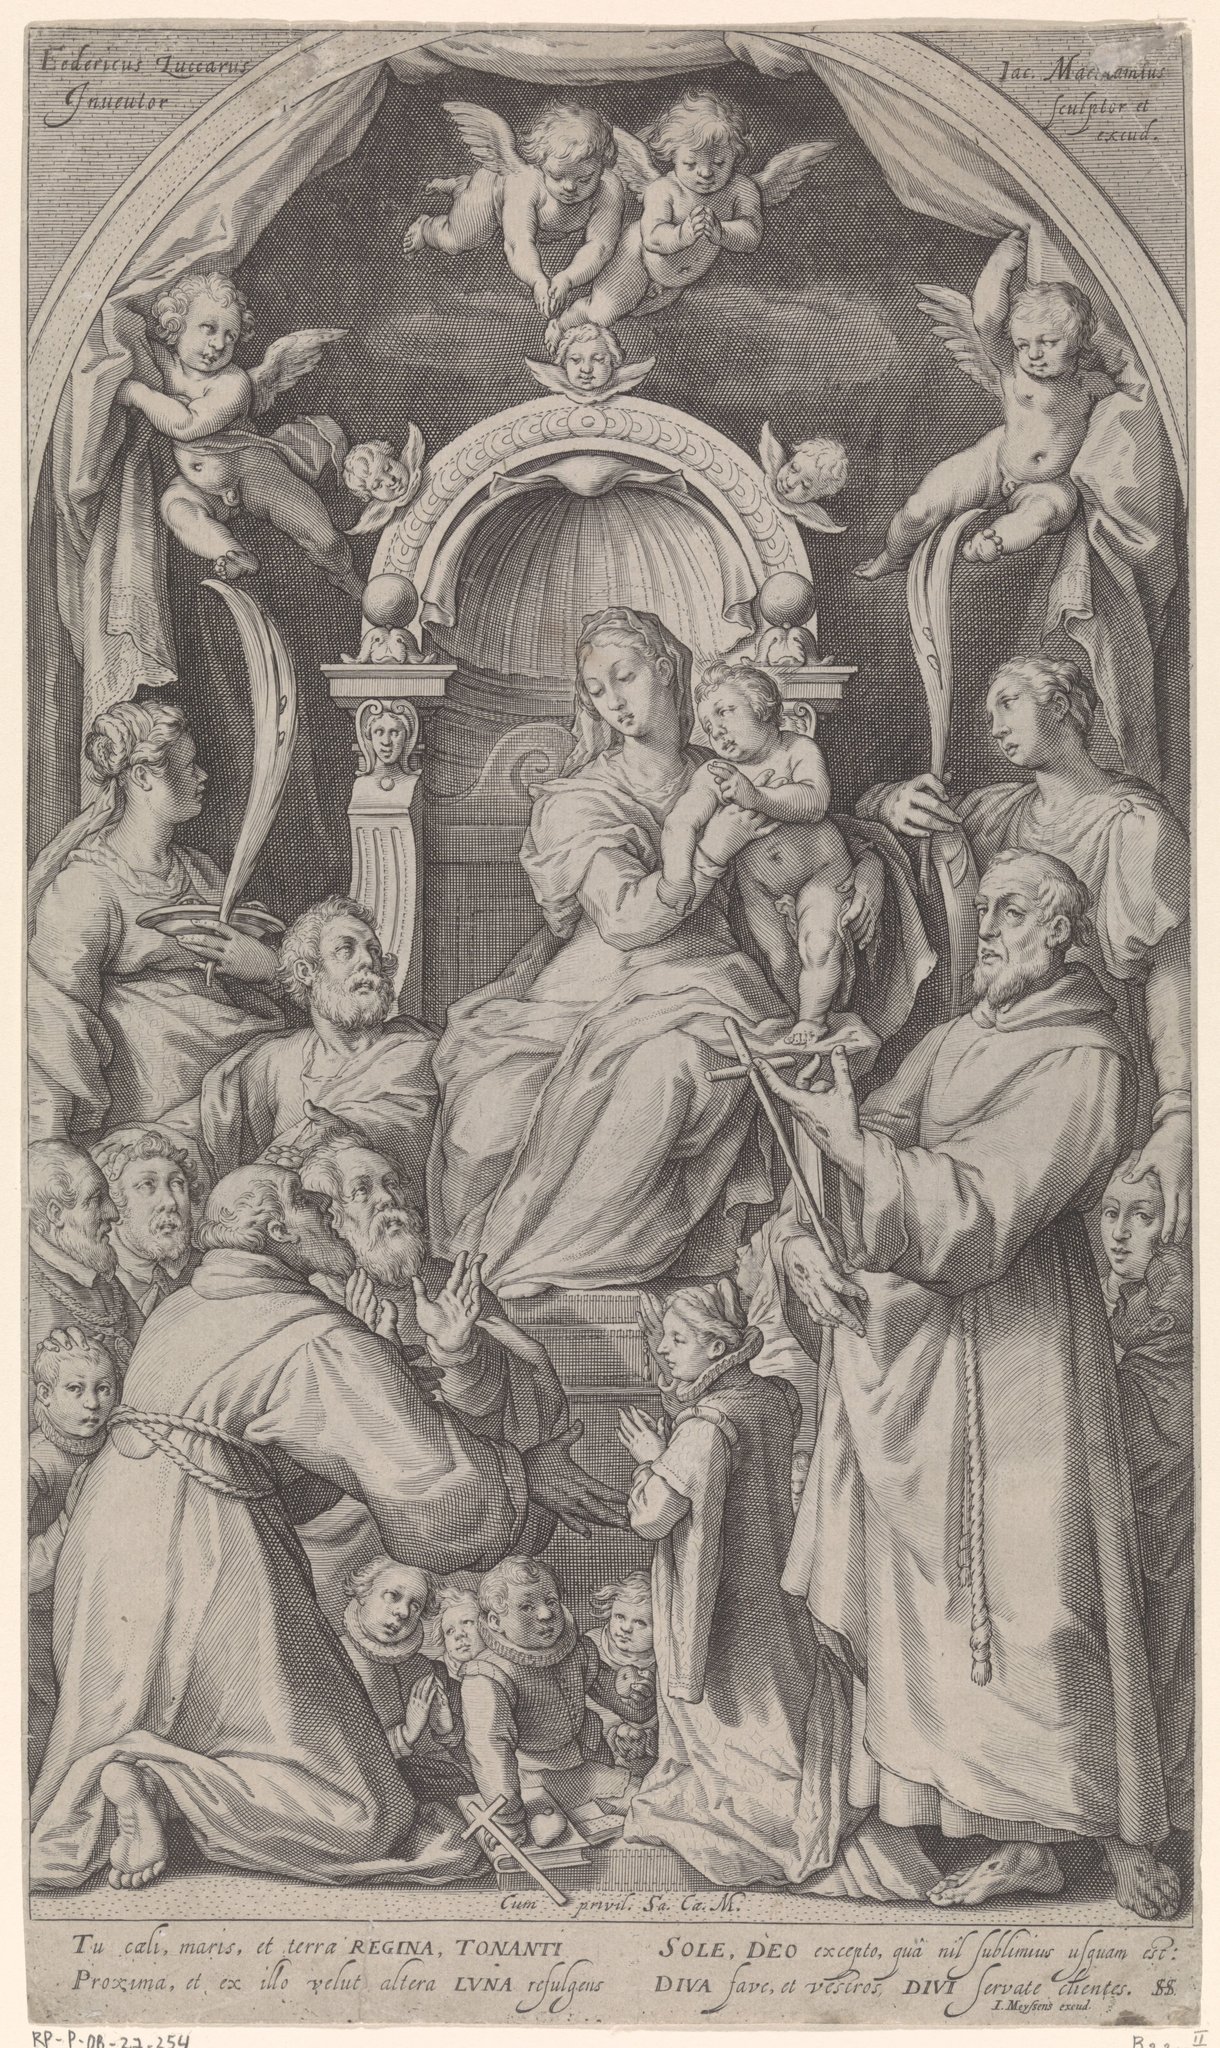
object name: print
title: Tronende Maria omringd door heiligen en donoren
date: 1604-1608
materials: paper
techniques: engraving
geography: antwerp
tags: madonna: i.e. mary with the christ-child (+ donor(s), supplicant(s), whether or not with patron saint(s)), mary enthroned (+ donor(s), supplicant(s), whether or not with patron saint(s)), madonna: mary sitting or enthroned, the christ-child in her lap (or in front of her bosom) (mary sometimes represented half-length) (+ donor(s), supplicant(s), whether or not with patron saint(s))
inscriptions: collector's mark: Lugt 2228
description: Tronende Maria met kind, omgeven door heiligen en donoren. Links de heilige Lucia met ogen op een schaal en rechts de heilige Catharina met haar rad. Rechts op de voorgrond de heilige Fransicus met de stigmata.